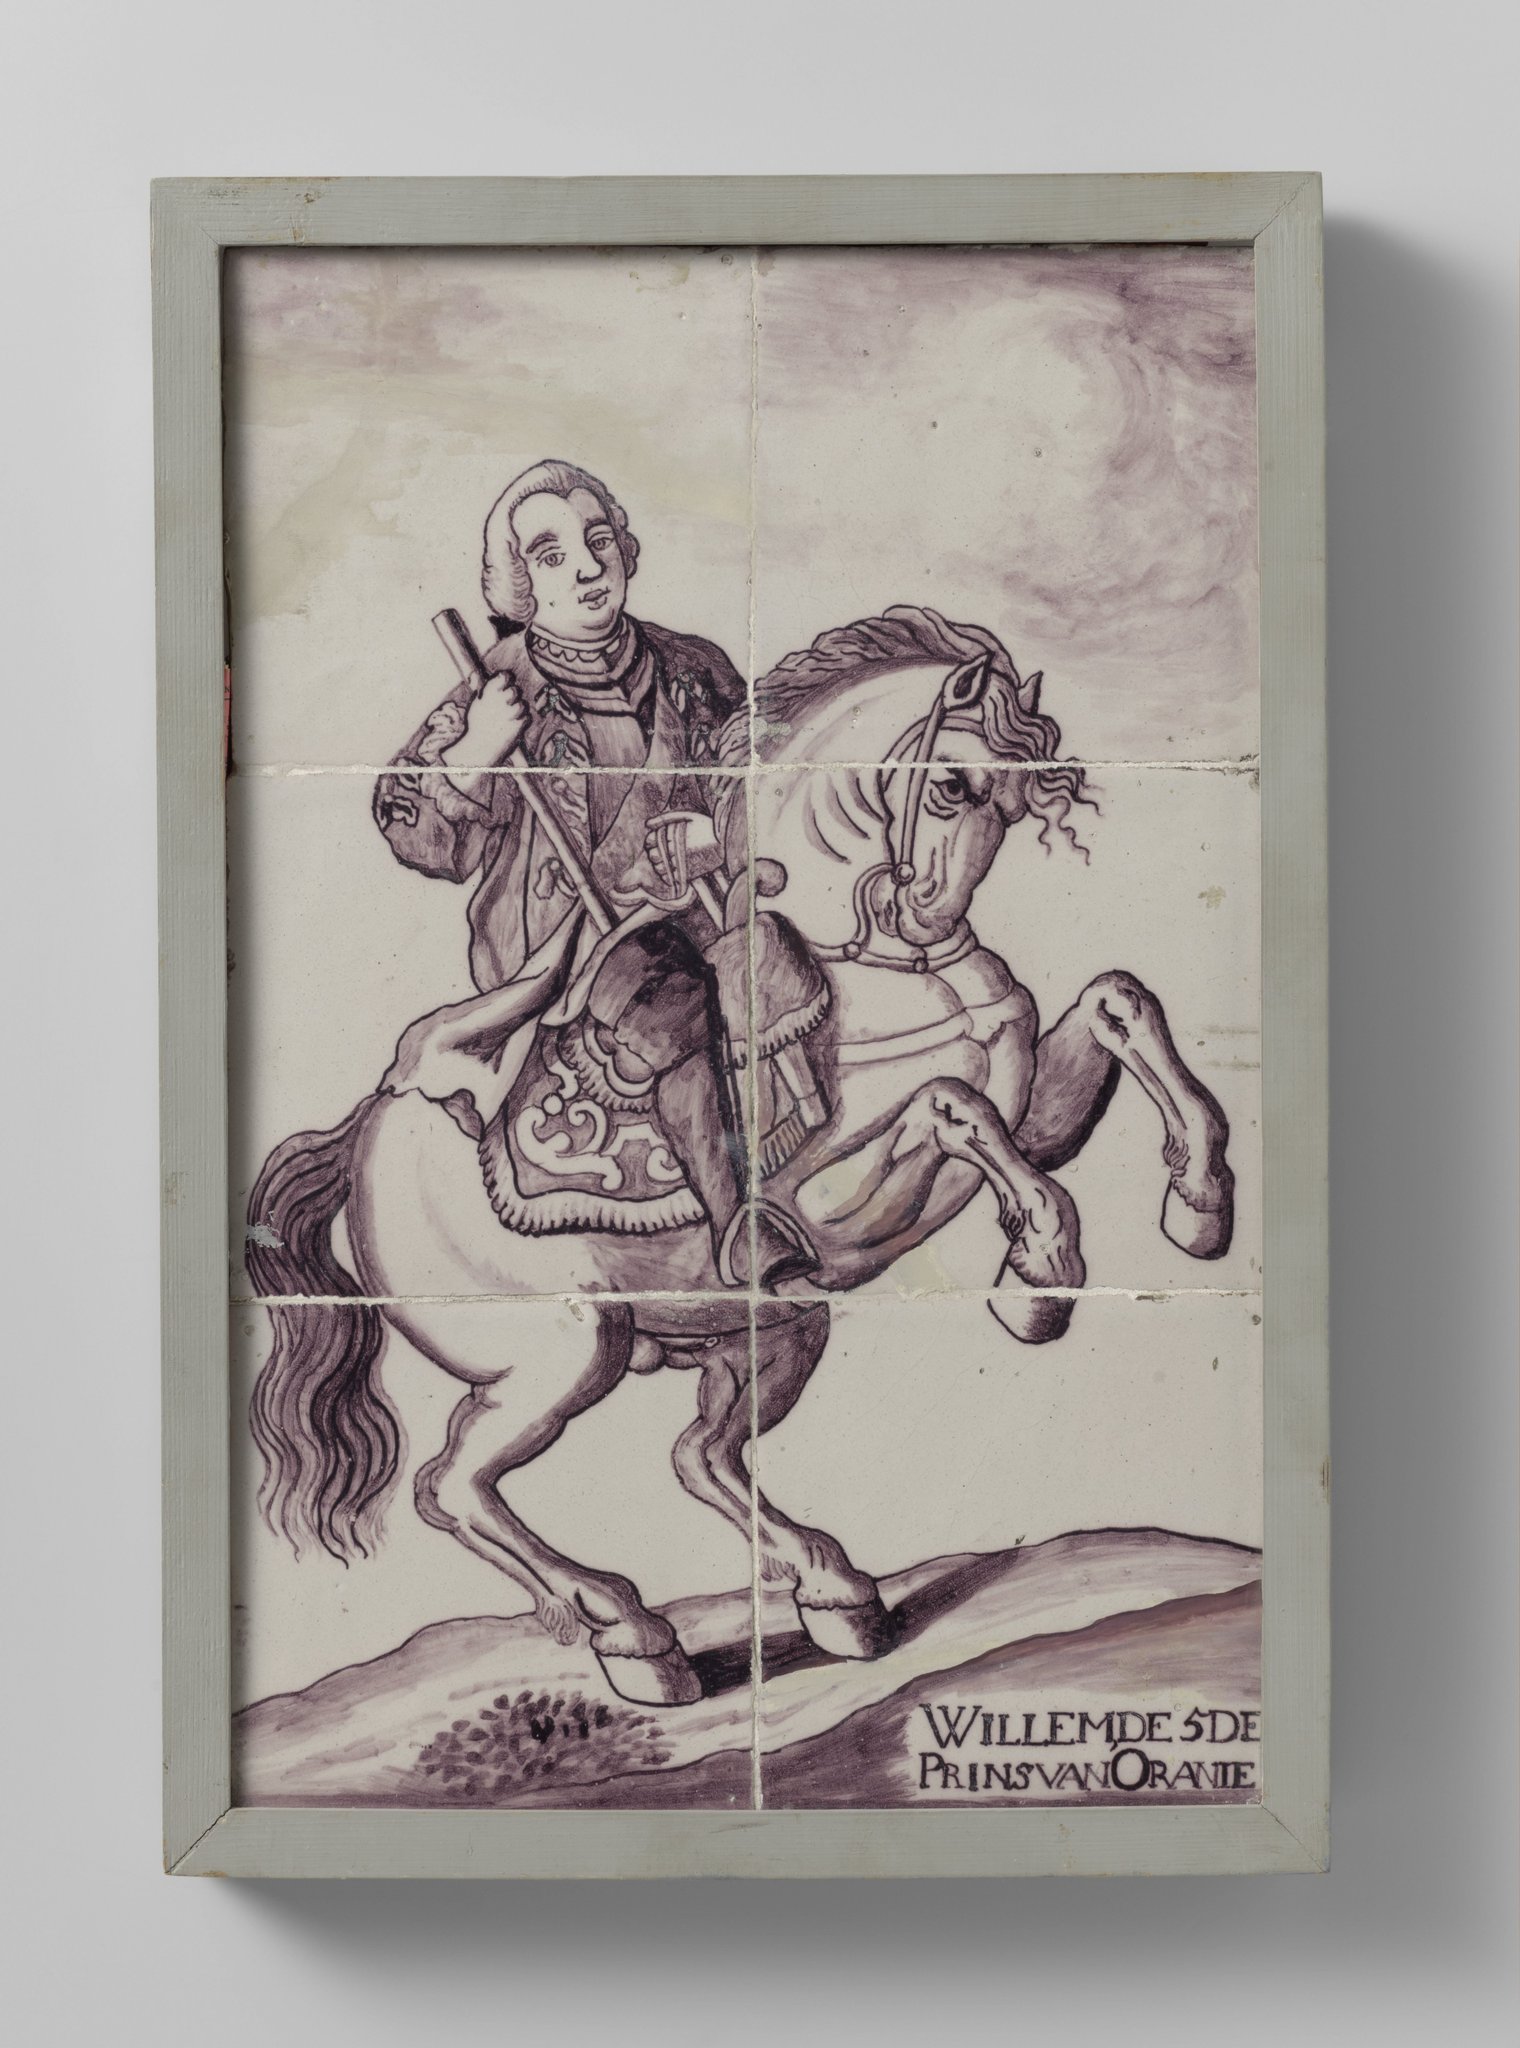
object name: tile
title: Tegeltableau met portret prins Willem V te paard, met opschrift: WILLEM DE 5DE PRINS VAN ORANIE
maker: Anonymous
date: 1760-1795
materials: earthenware, glaze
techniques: maiolica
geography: netherlands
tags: the hague, william v (prince of orange)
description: Tegeltableau van 6 tegels (3 x 2) met een paarse voorstelling van prins Willem V te paard. Rechts onder, het opschrift: WILLEM DE 5DE, PRINS VAN ORANIE. Zie pendant: BK-NM-5203.